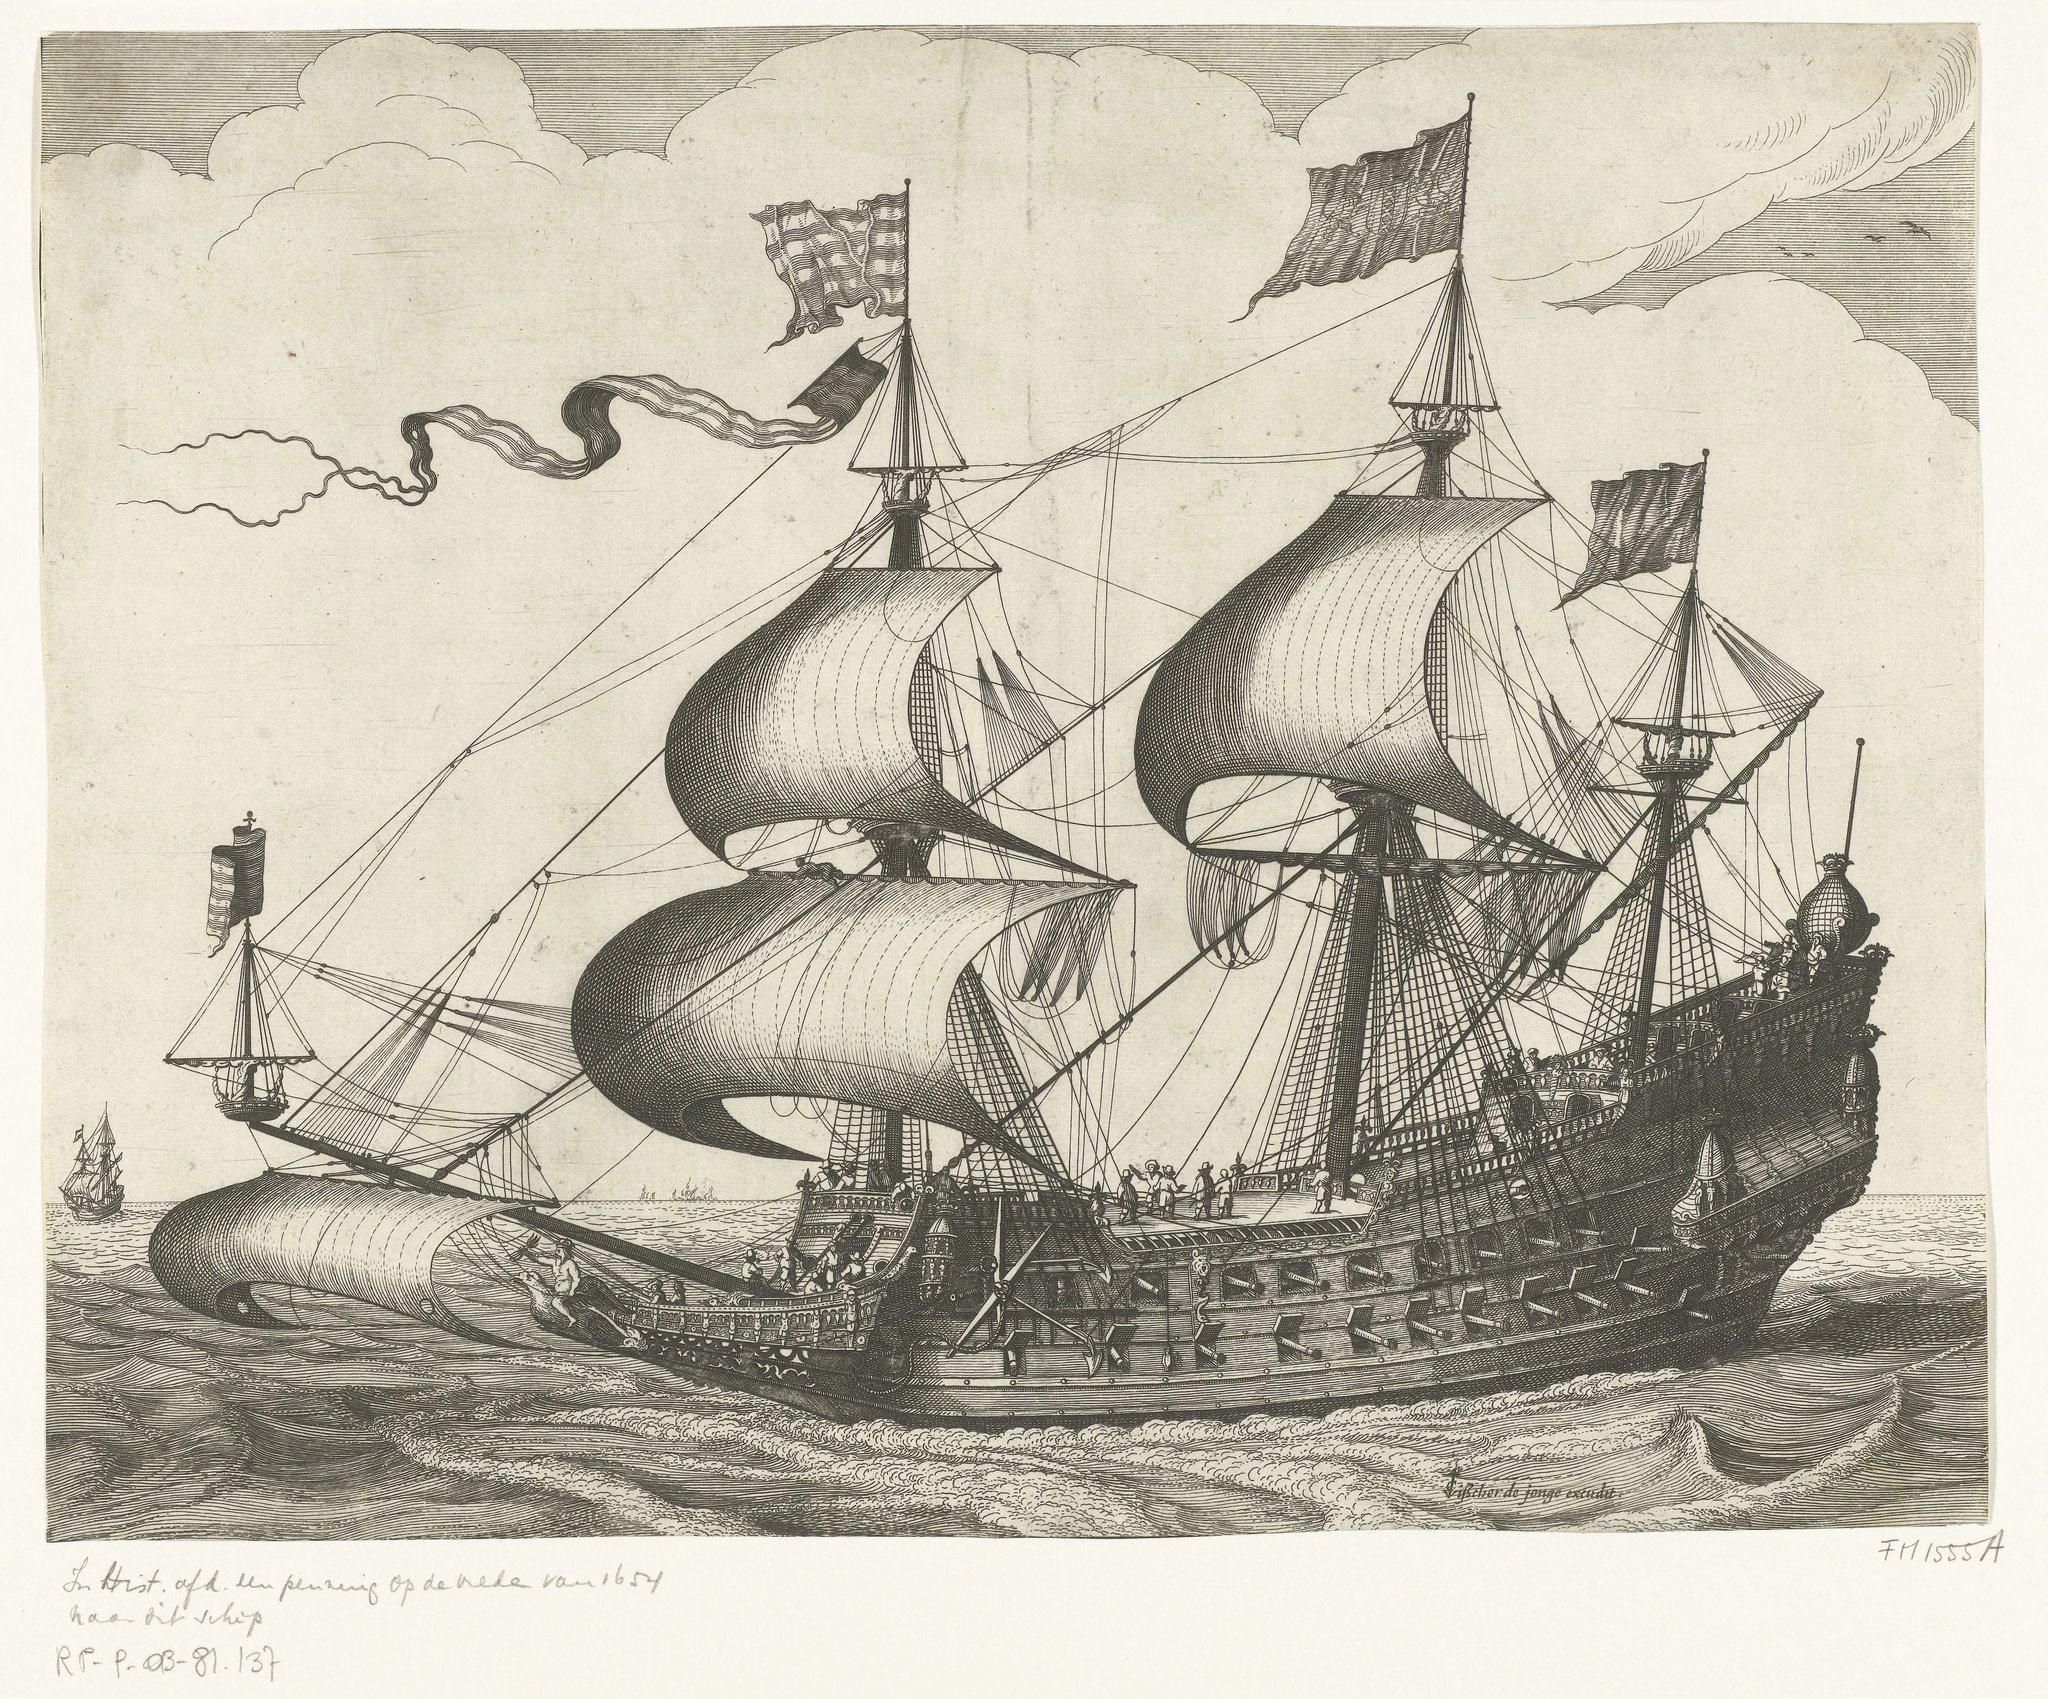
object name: print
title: Nederlands oorlogsschip met drie masten, ca. 1625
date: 1625-1652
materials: paper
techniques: engraving, etching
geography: amsterdam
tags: ships (in general) (+ propulsion of vehicle, ship, etc. by wind), warfare; military affairs (+ sailing-ships)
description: Een Nederlands oorlogsschip met drie masten, ca. 1625. Groot oorlogsschip in volle lengte op volle zee, met uitgezette zeilen; met drie masten met verschillende vlaggen, in het midden de vlag van Amsterdam.